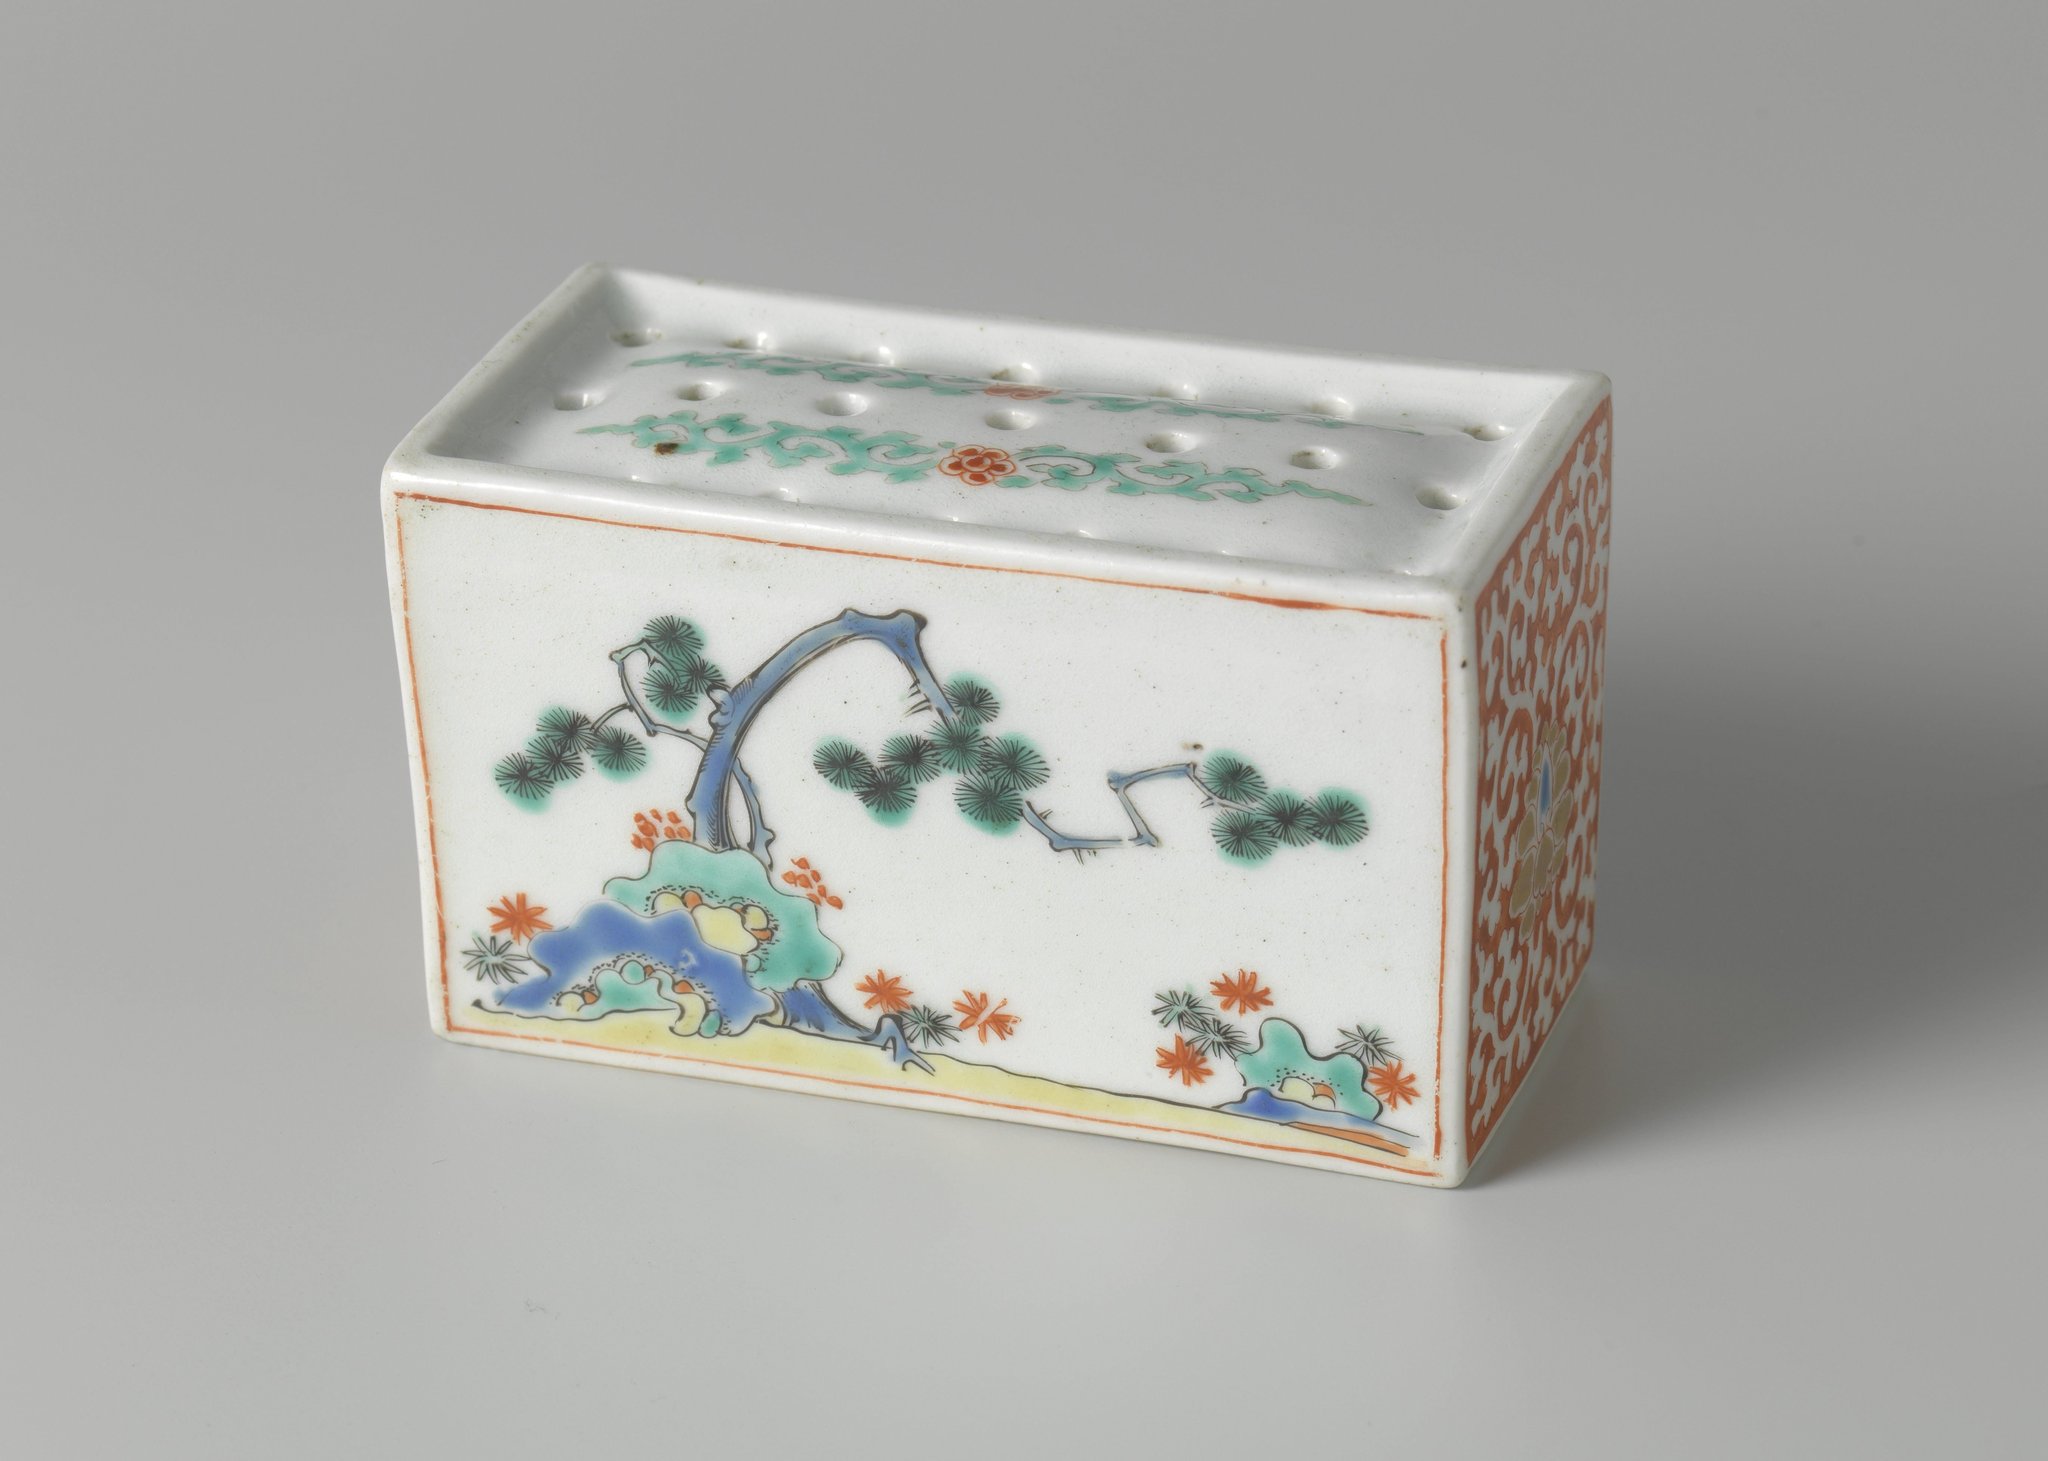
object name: sander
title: Rectangular sand brick with prunus, pine tree and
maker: Anonymous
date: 1670-1690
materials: glaze, porcelain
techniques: gilding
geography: arita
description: Sander c. 1690 - 1710